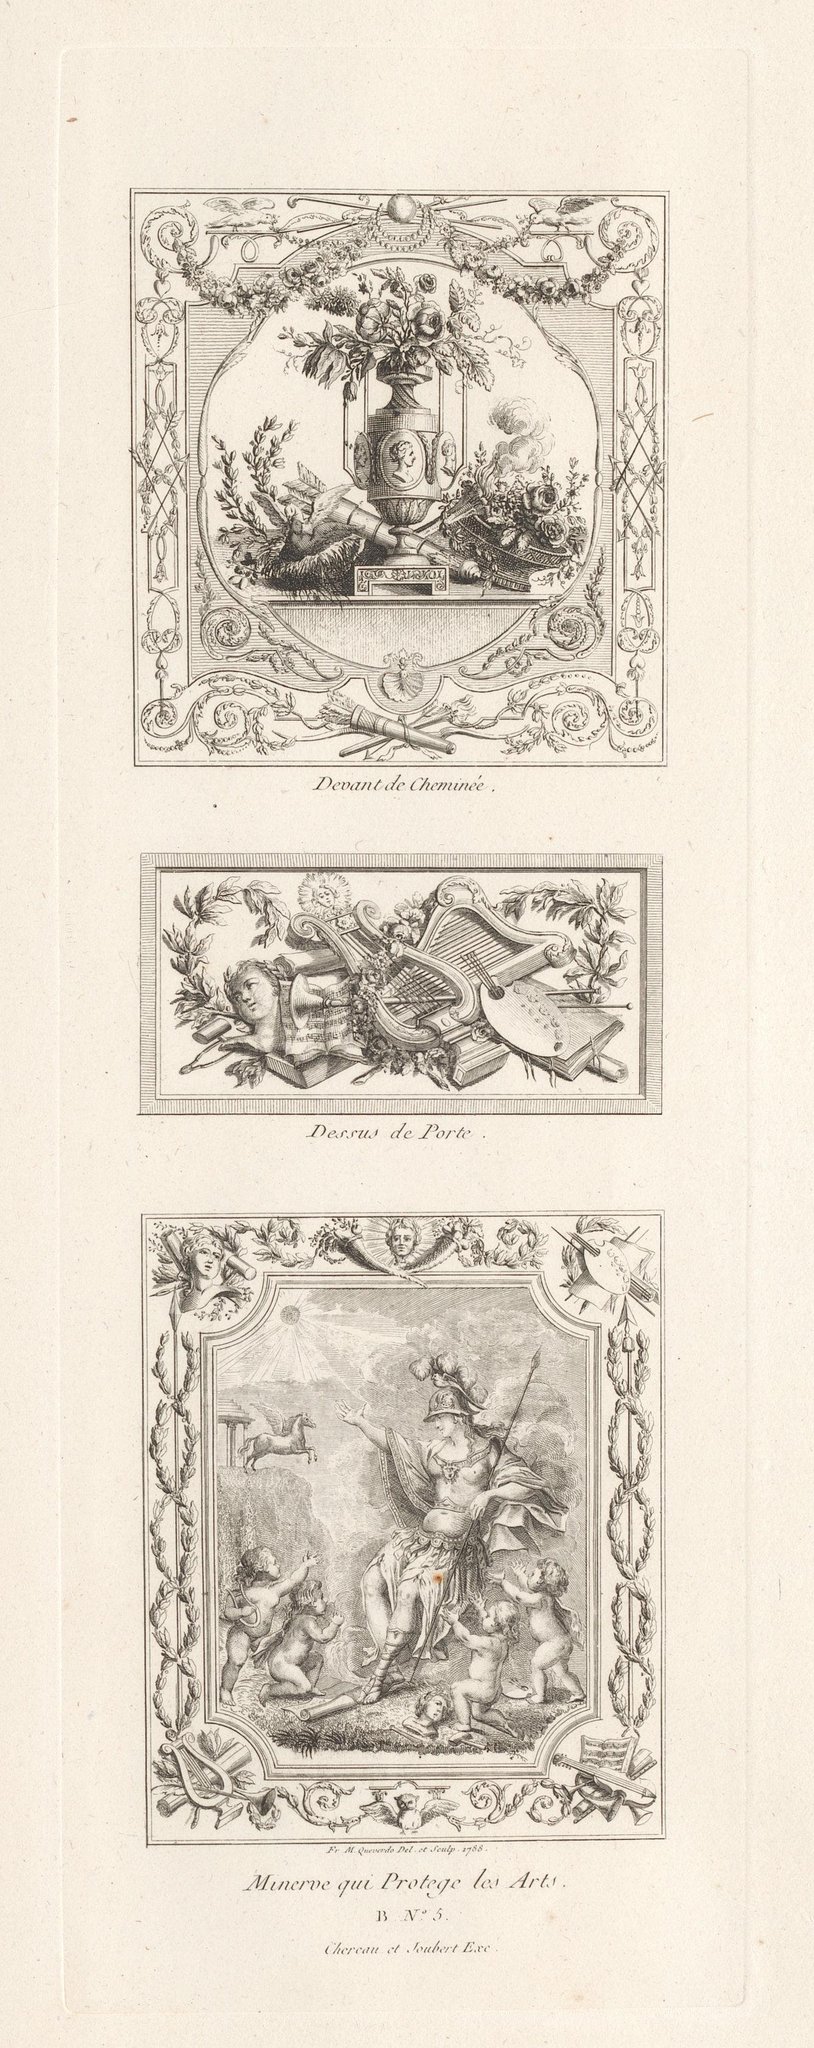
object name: album leaf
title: Deuxieme cayer de panneaux, frises et sujets arabesques composés et gravés par Fr. M. Queverdo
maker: françois marie isidore queverdo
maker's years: 1748-1797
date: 1788-1802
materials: paper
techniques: etching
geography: paris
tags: pegasus, the winged horse, minerva as patroness, ornament ~ arabesque, lyre, cithara, psaltery, harp, symbolic representations, allegories and emblems ~ art; 'arte' (ripa), palette, cupids: 'amores', 'amoretti', 'putti', ornament derived from plant forms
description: Doordat dit album bestaat uit meerdere, deels eerder uitgegeven prentreeksen, is de datering niet consequent. Het geheel is op de titelpagina gedateerd op 1802. Deze reeks is gedateerd op 1788. De serietitel voor het gehele werk is "Recueil d'arabesques, contenant les loges du Vatican". De andere serietitel is de titel van de specifieke reeks binnen het geheel.